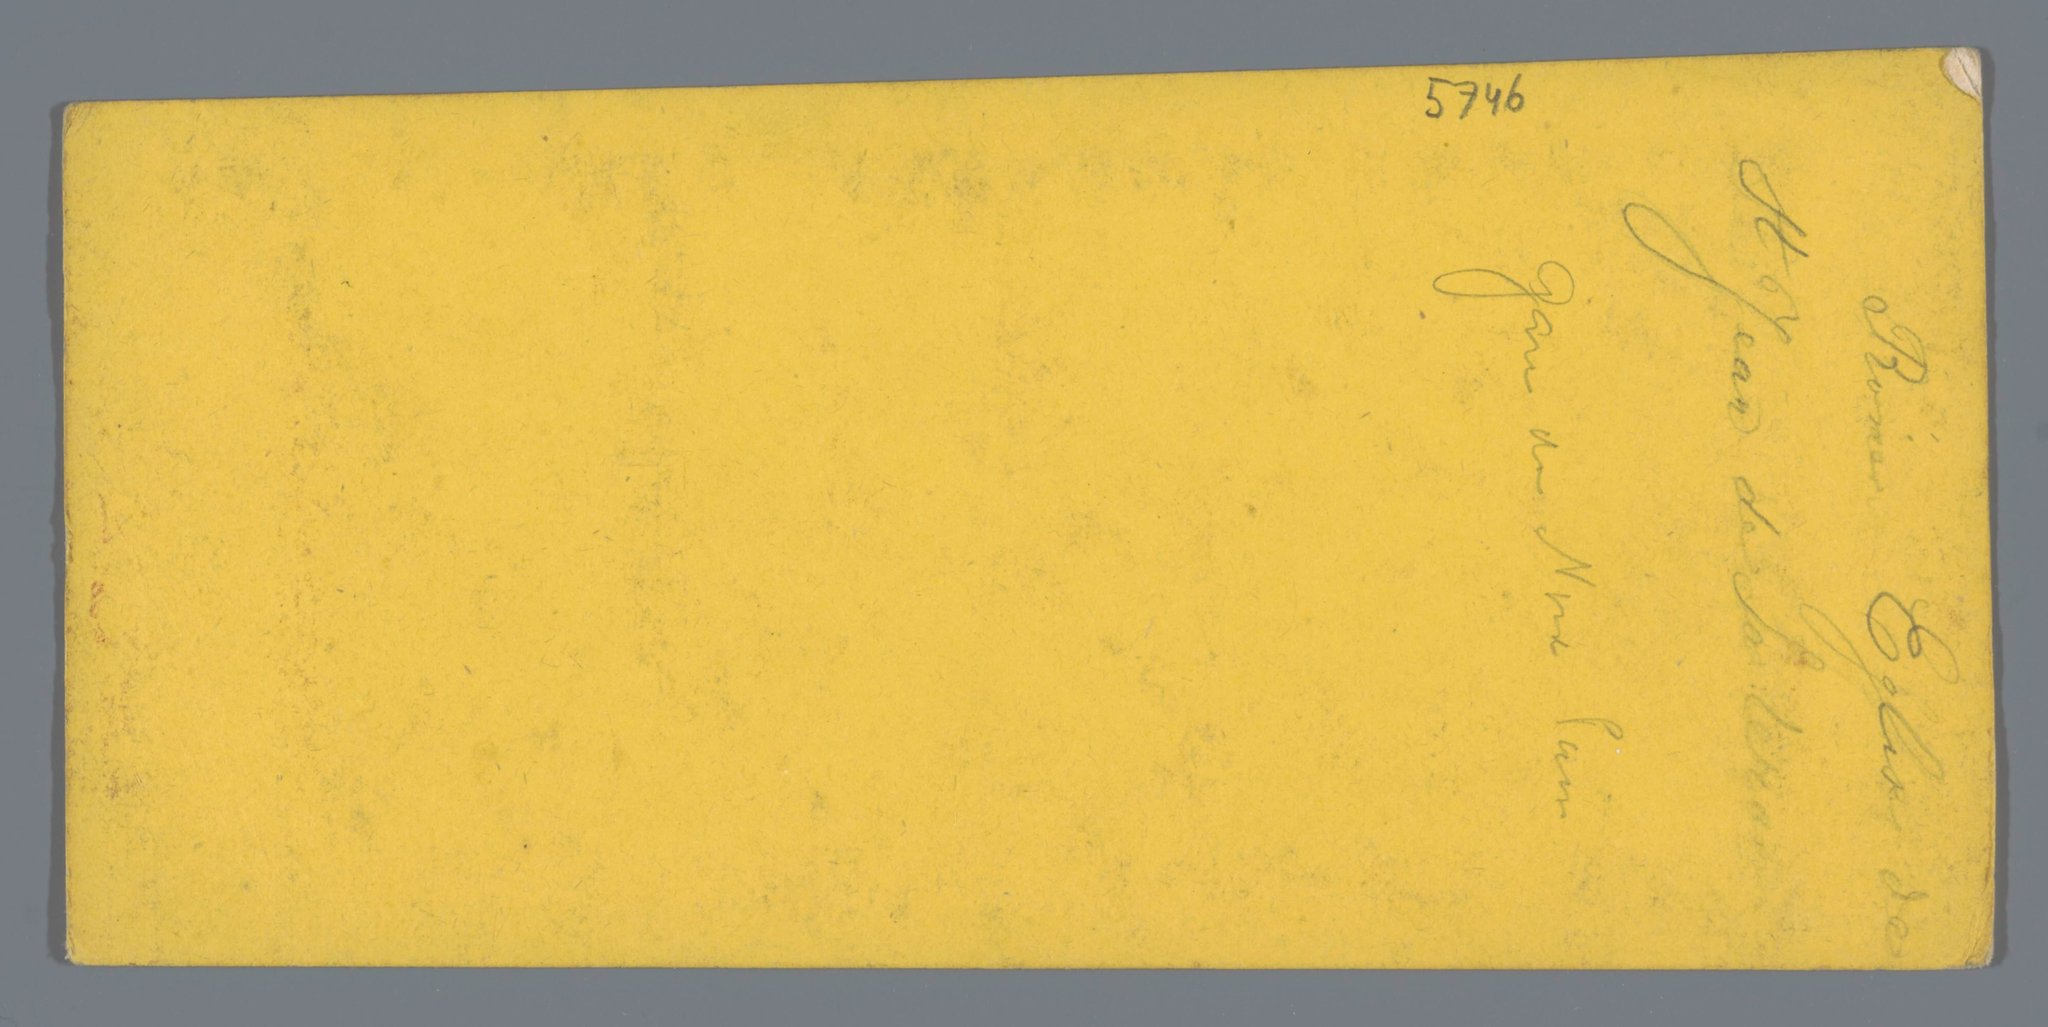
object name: stereograph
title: Gezicht op het treinstation Gare du Nord in Parijs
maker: Anonymous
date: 1850-1880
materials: cardboard, photographic support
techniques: albumen print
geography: paris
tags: animal traction, animal-drawn vehicle (carriage etc.), station; shelter (railway, tramway)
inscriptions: inscription: ‘Rome Eglise de h Jean de Lateran gare du Nord Paris’